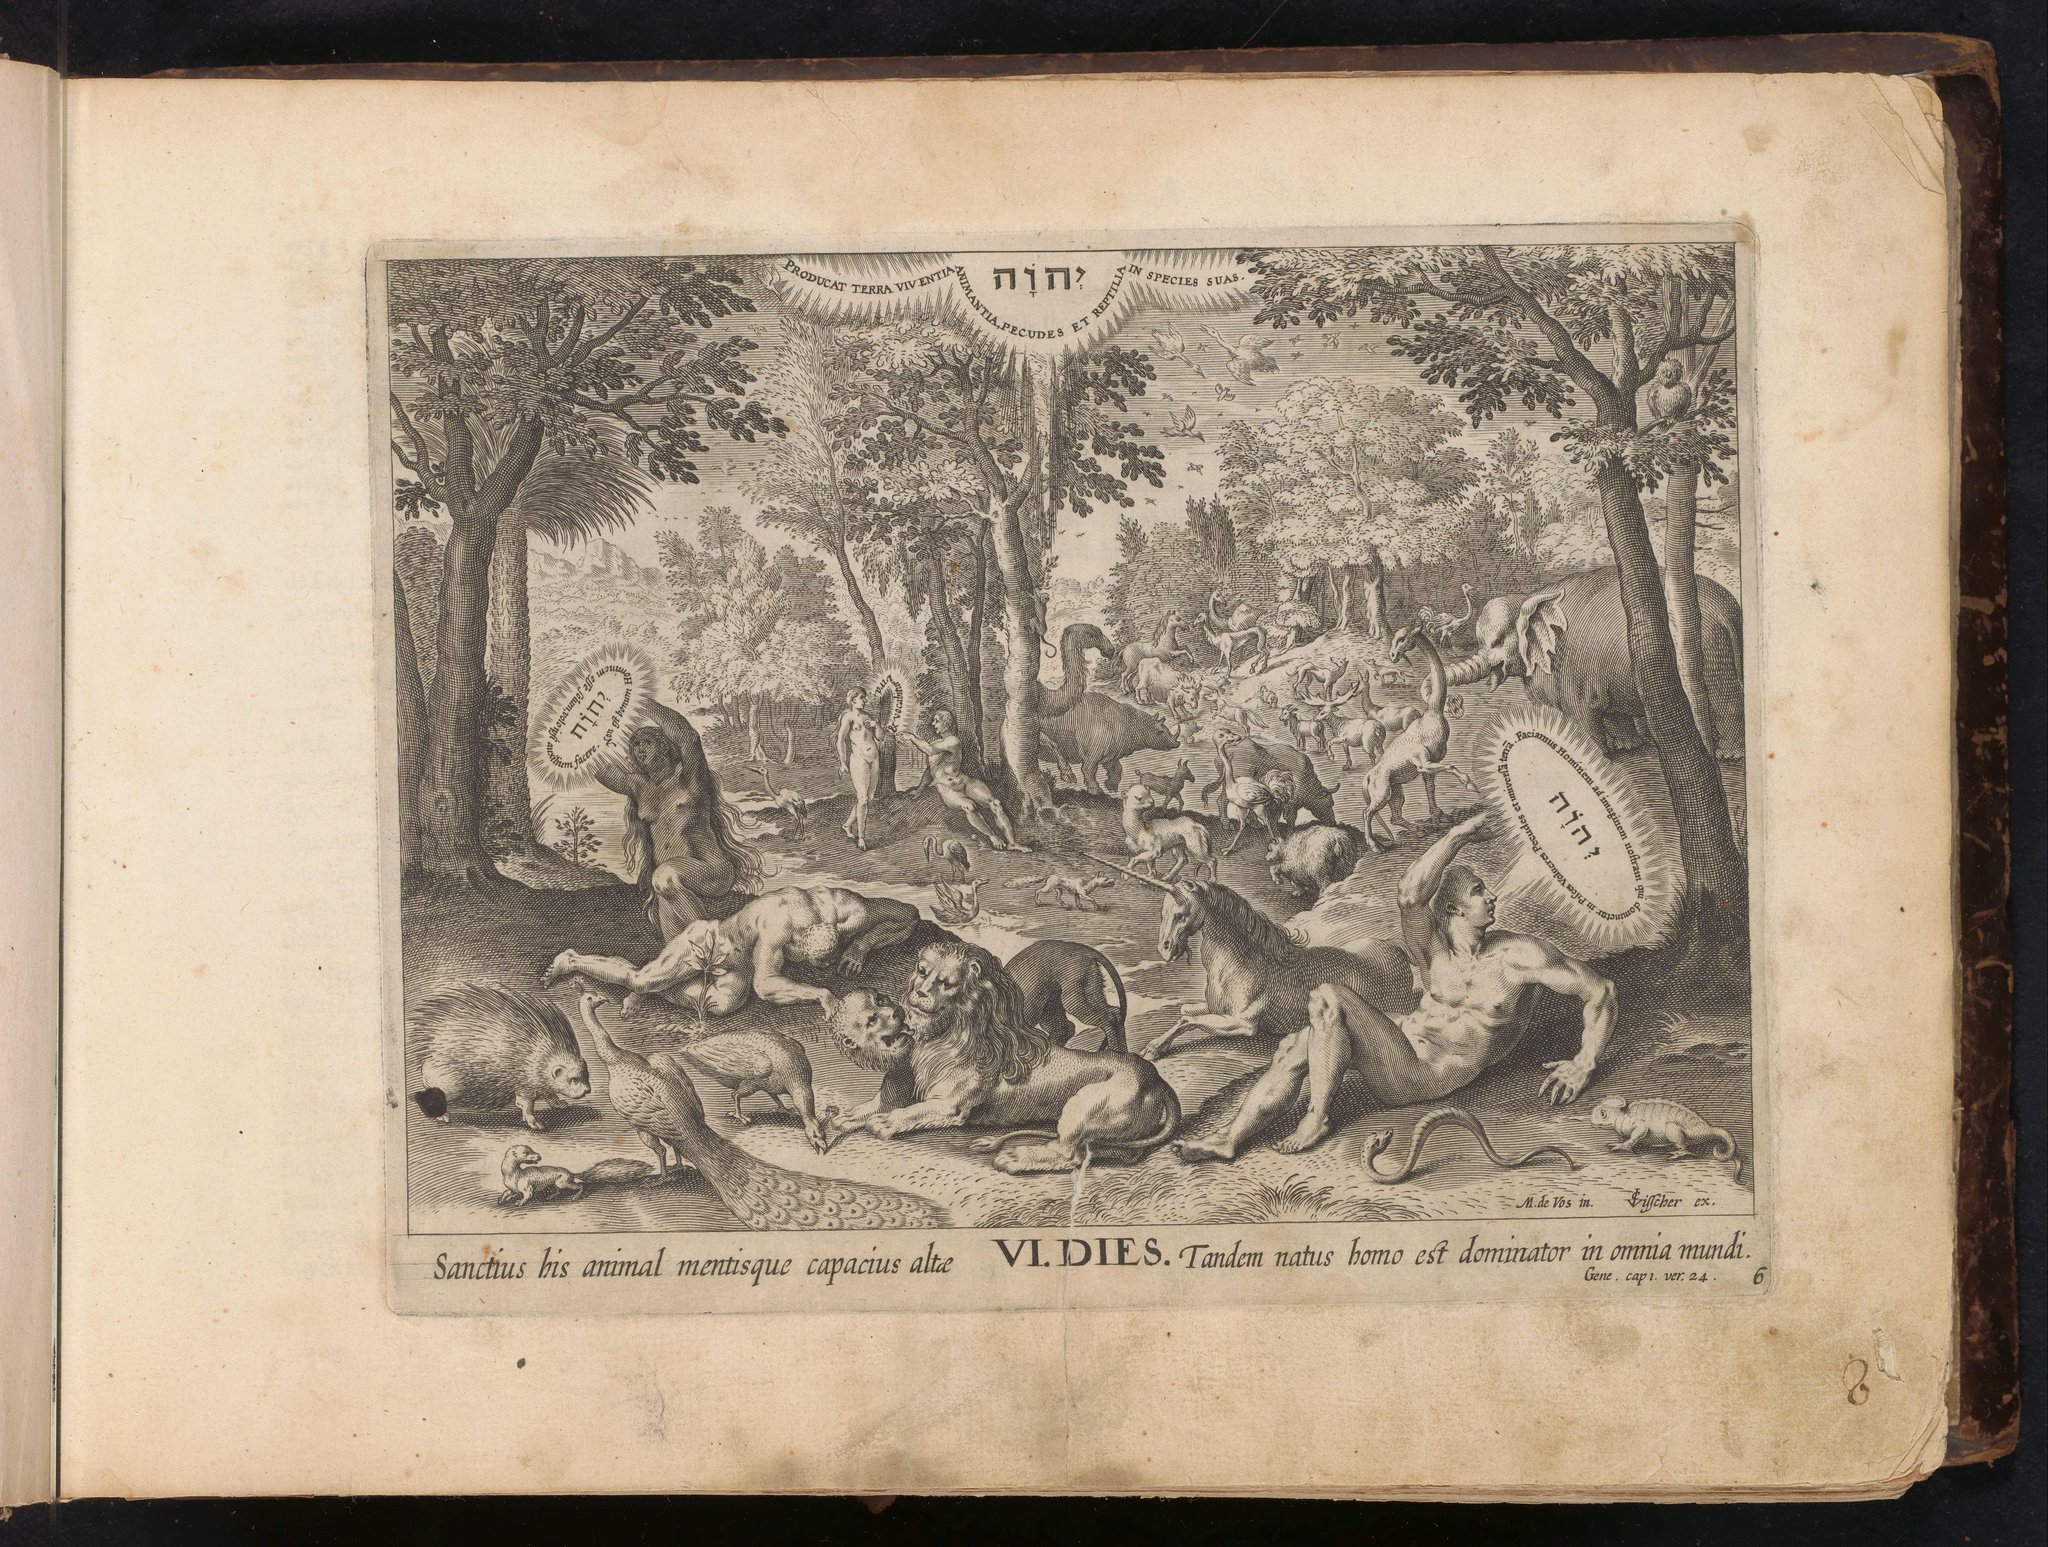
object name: album leaf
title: Schepping van de wereld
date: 1639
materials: paper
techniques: engraving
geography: alkmaar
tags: creation of man; the garden of eden (genesis 1:26 - 2), unicorn, animals, creation of eve, tetragram (in roman or hebrew script) ~ symbol of god the father, beasts of prey, predatory animals: lion, creation of land-animals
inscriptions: number: ‘8’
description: Te midden van de dieren worden Adam en Eva geschapen door God de Vader in de vorm van een tetragram. Rechts op de voorgrond buigt God zich over Adam; links wordt Eva uit de rib van Adam geschapen. In het midden twee leeuwen, een eenhoorn en andere dieren. In het midden op de achtergrond geeft God Eva aan Adam. Op de zesde dag van de schepping schiep God Adam en Eva. Onder de voorstelling een verwijzing in het Latijn naar de Bijbeltekst in Gen. 1:24. Deze prent maakt deel uit van een album.